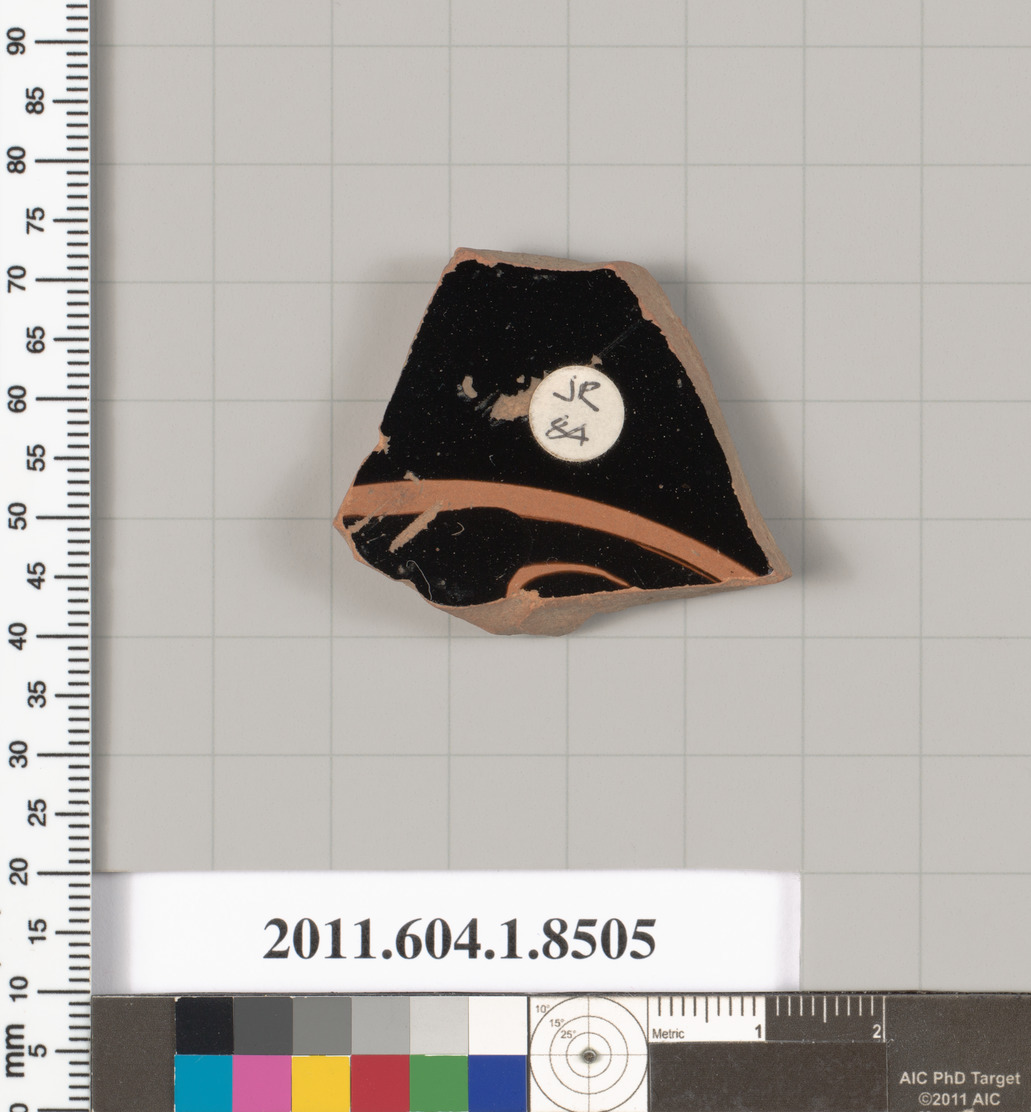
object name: kylix fragment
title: Terracotta fragment of a stemless kylix (drinking cup)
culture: greek, attic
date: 470-450 BCE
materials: terracotta